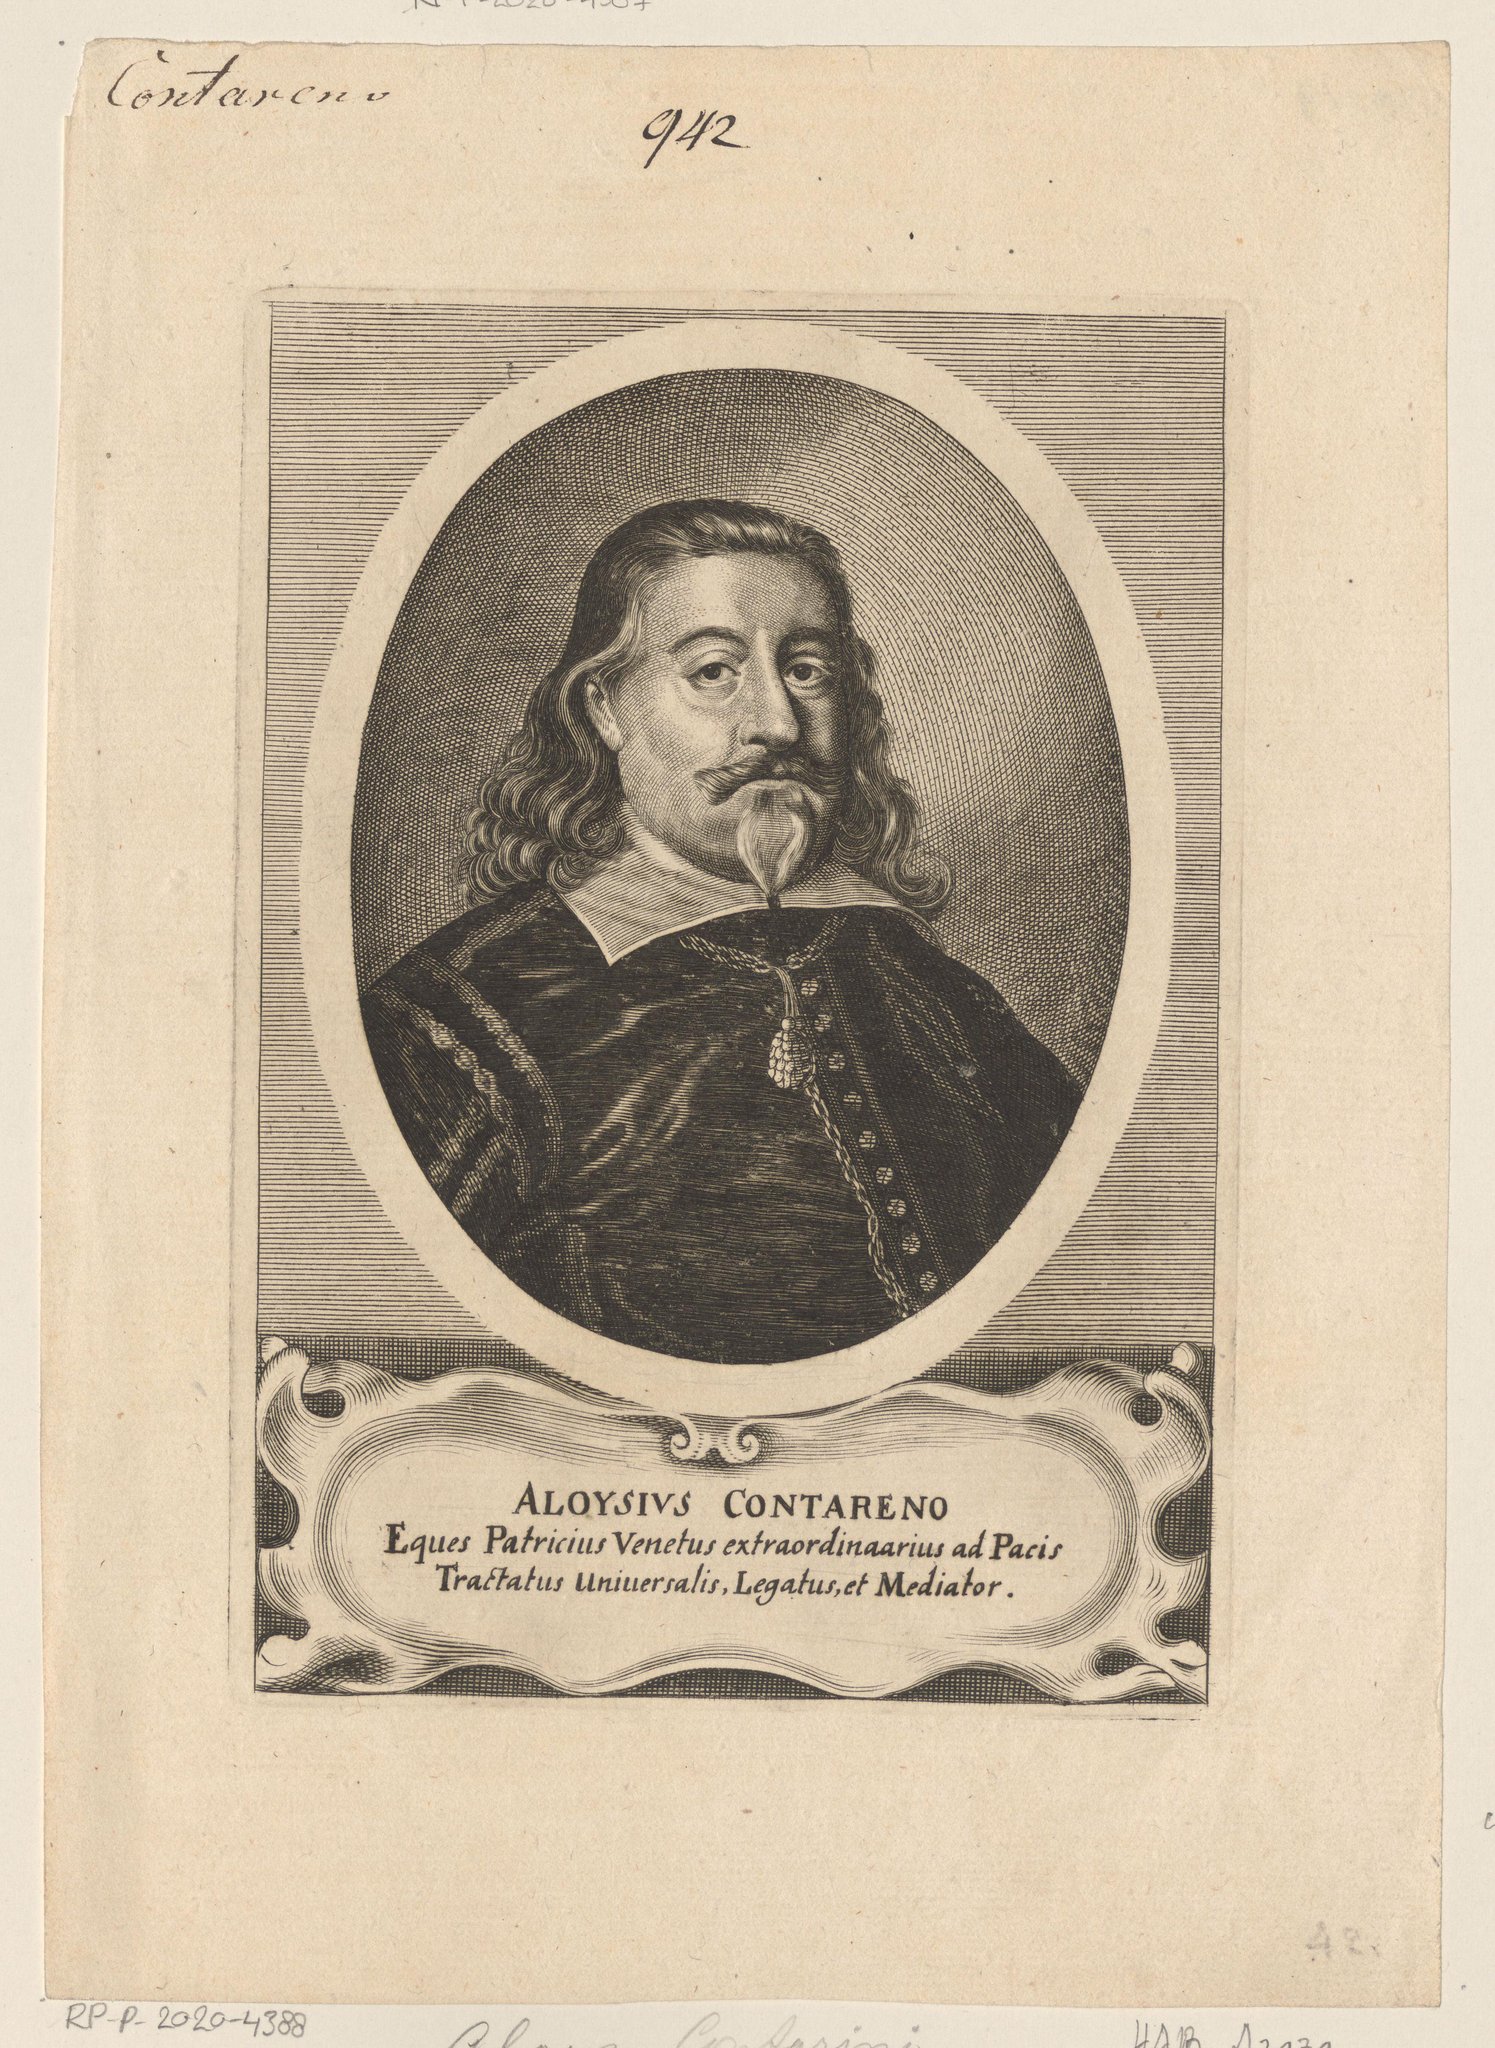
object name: print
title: Portret van Aloysius Contareno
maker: Anonymous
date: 1652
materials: paper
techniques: engraving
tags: historical persons, ruler, sovereign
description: Prent met andere tekst op verso gebruikt in: Theatrum Europaeum (...). Frankfurt am Main: erven Matthäus Merian I, 1652.